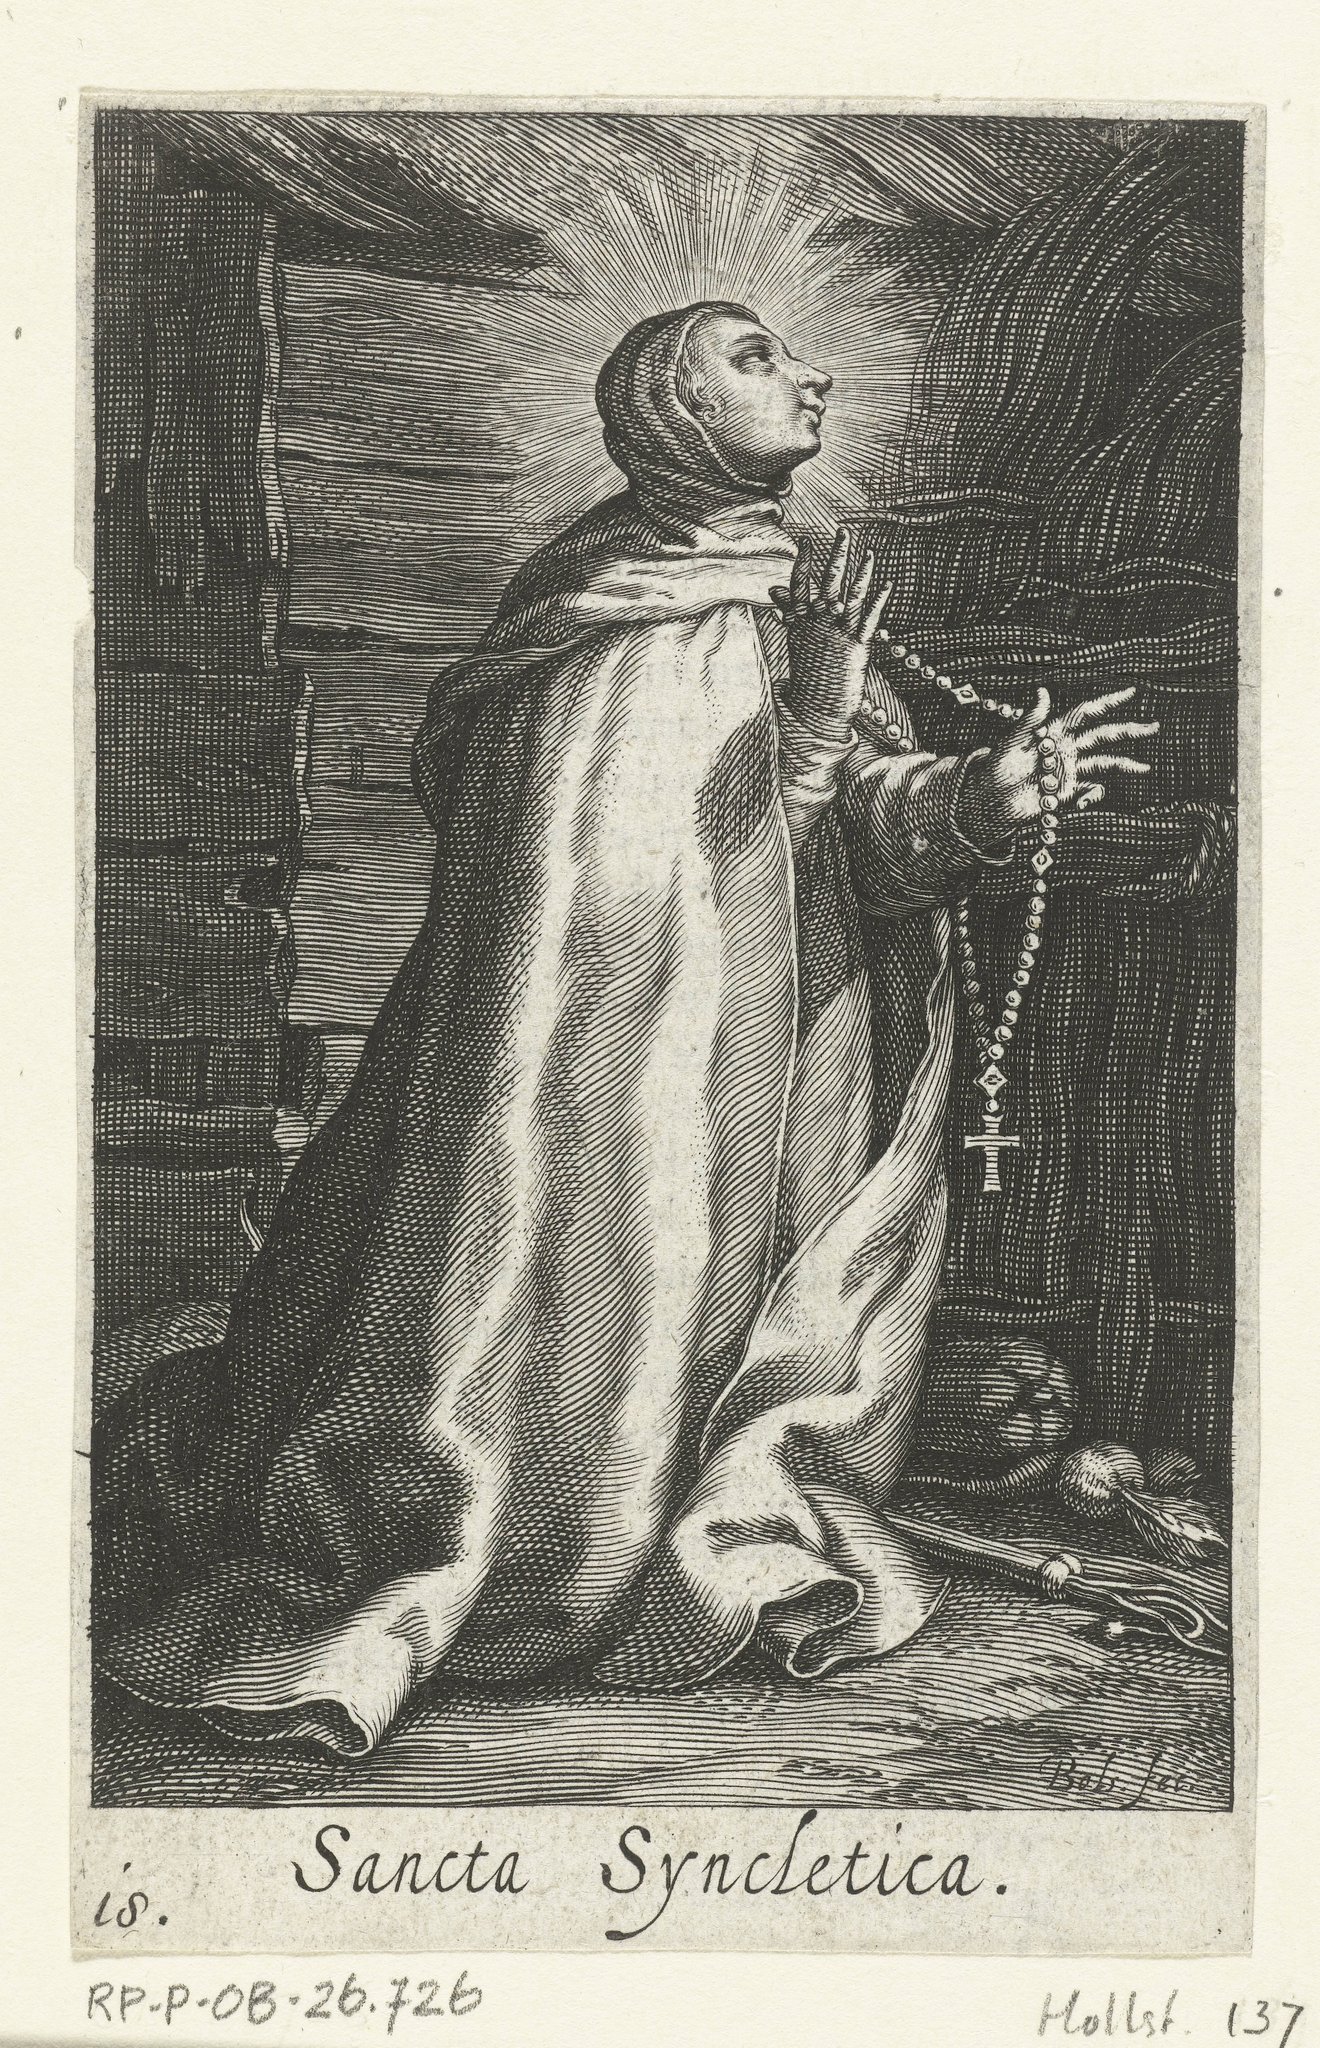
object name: book illustration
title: Sacra Eremus Ascetriarum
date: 1590-1612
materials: paper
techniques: engraving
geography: antwerp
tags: anchorite, hermit, female saints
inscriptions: collector's mark: Lugt 2228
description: Prent uit: Sacra Eremus Ascetriarum, Hendrik Aertssen, Antwerpen 1619. Prent uit de serie van vijfentwintig kluizenaressen in deze uitgave. In 1612 verscheen de ongebonden editie maar op basis van de gewijzigde opschriften en samenstelling van de serie kluizenaars wordt aangenomen dat de prenten van de uitgave 1619 ook in 1612 of iets daarvoor gedrukt werden. De serie kluizenaressen bleef vrijwel ongewijzigd in de ongebonden uitgave van 1612, dit compliceert de datering van de losse bladen in de collectie van het RMA, zie Roethlisberger 1993, p. 171-175. Door de aanwezigheid van Franse tekst op het verso kunnen we vaststellen dat dit blad afkomstig is uit de Antwerpse uitgave van 1619.